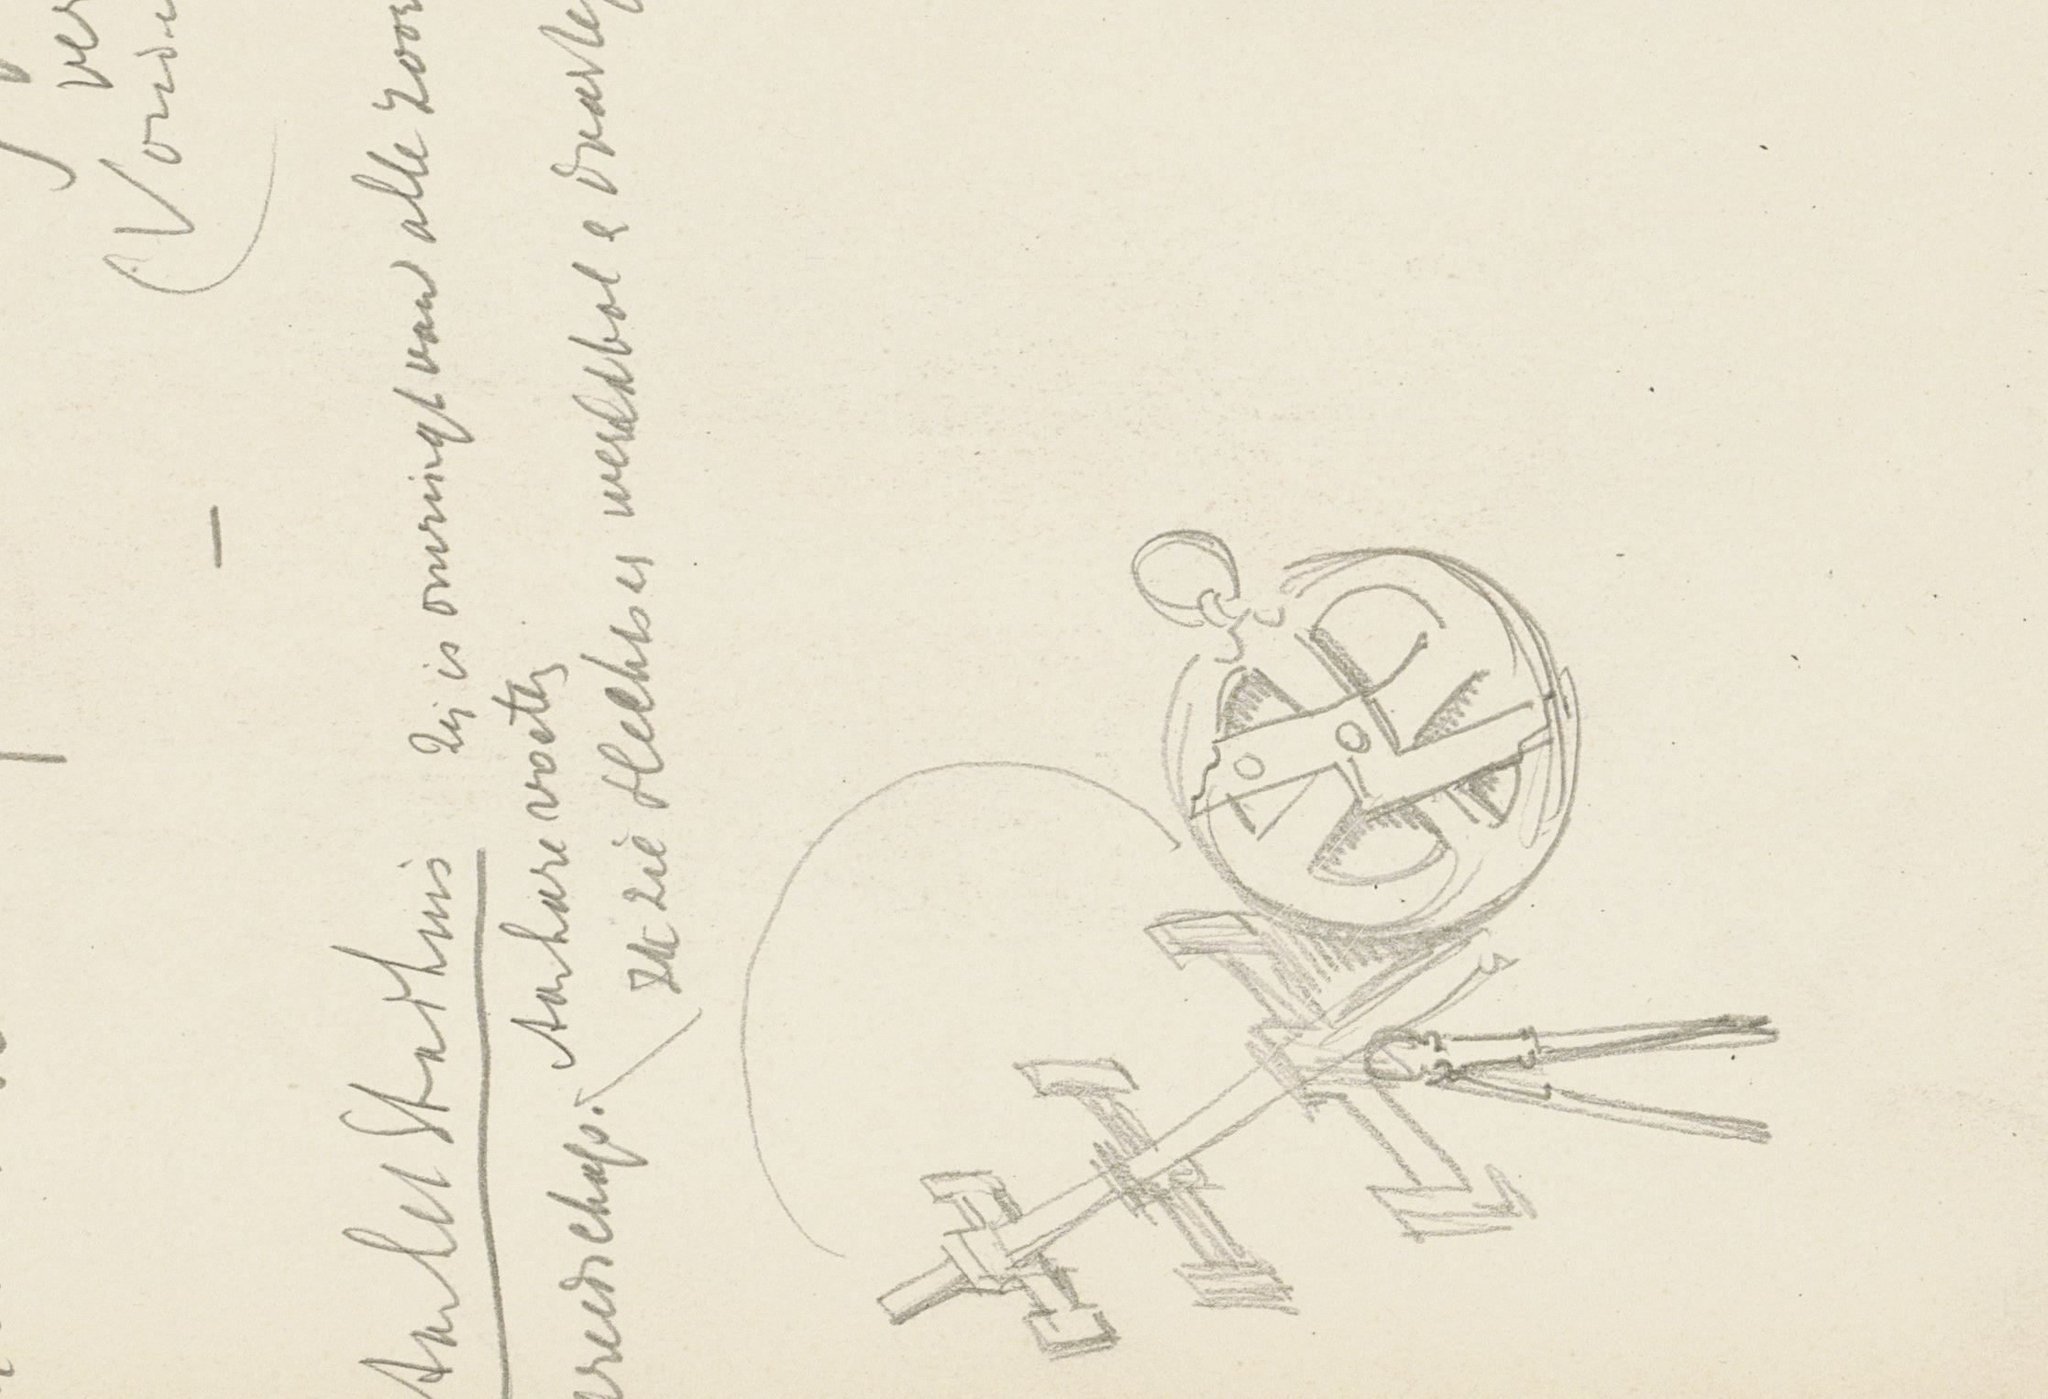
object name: sketchbook leaf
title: Instrumenten, waaronder een passer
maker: antoon derkinderen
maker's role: draughtsman, painter, print maker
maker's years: 1859-1925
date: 1900-1903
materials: paper, pencil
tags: compasses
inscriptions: annotation: ‘Des wijzes koopman slacht, die 't beste deel/ verkiest/ En om de schoonste peerle is weinig goeds/ versiert/ (Vondel)/ Aan het Stadhuis Zij is omringd van alle roosters van lei-/ gereedschap. Aan hare voeten/ Ik zie Hel[...] wereldbol & [...]’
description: Blad 18 verso uit een schetsboek met 45 bladen.